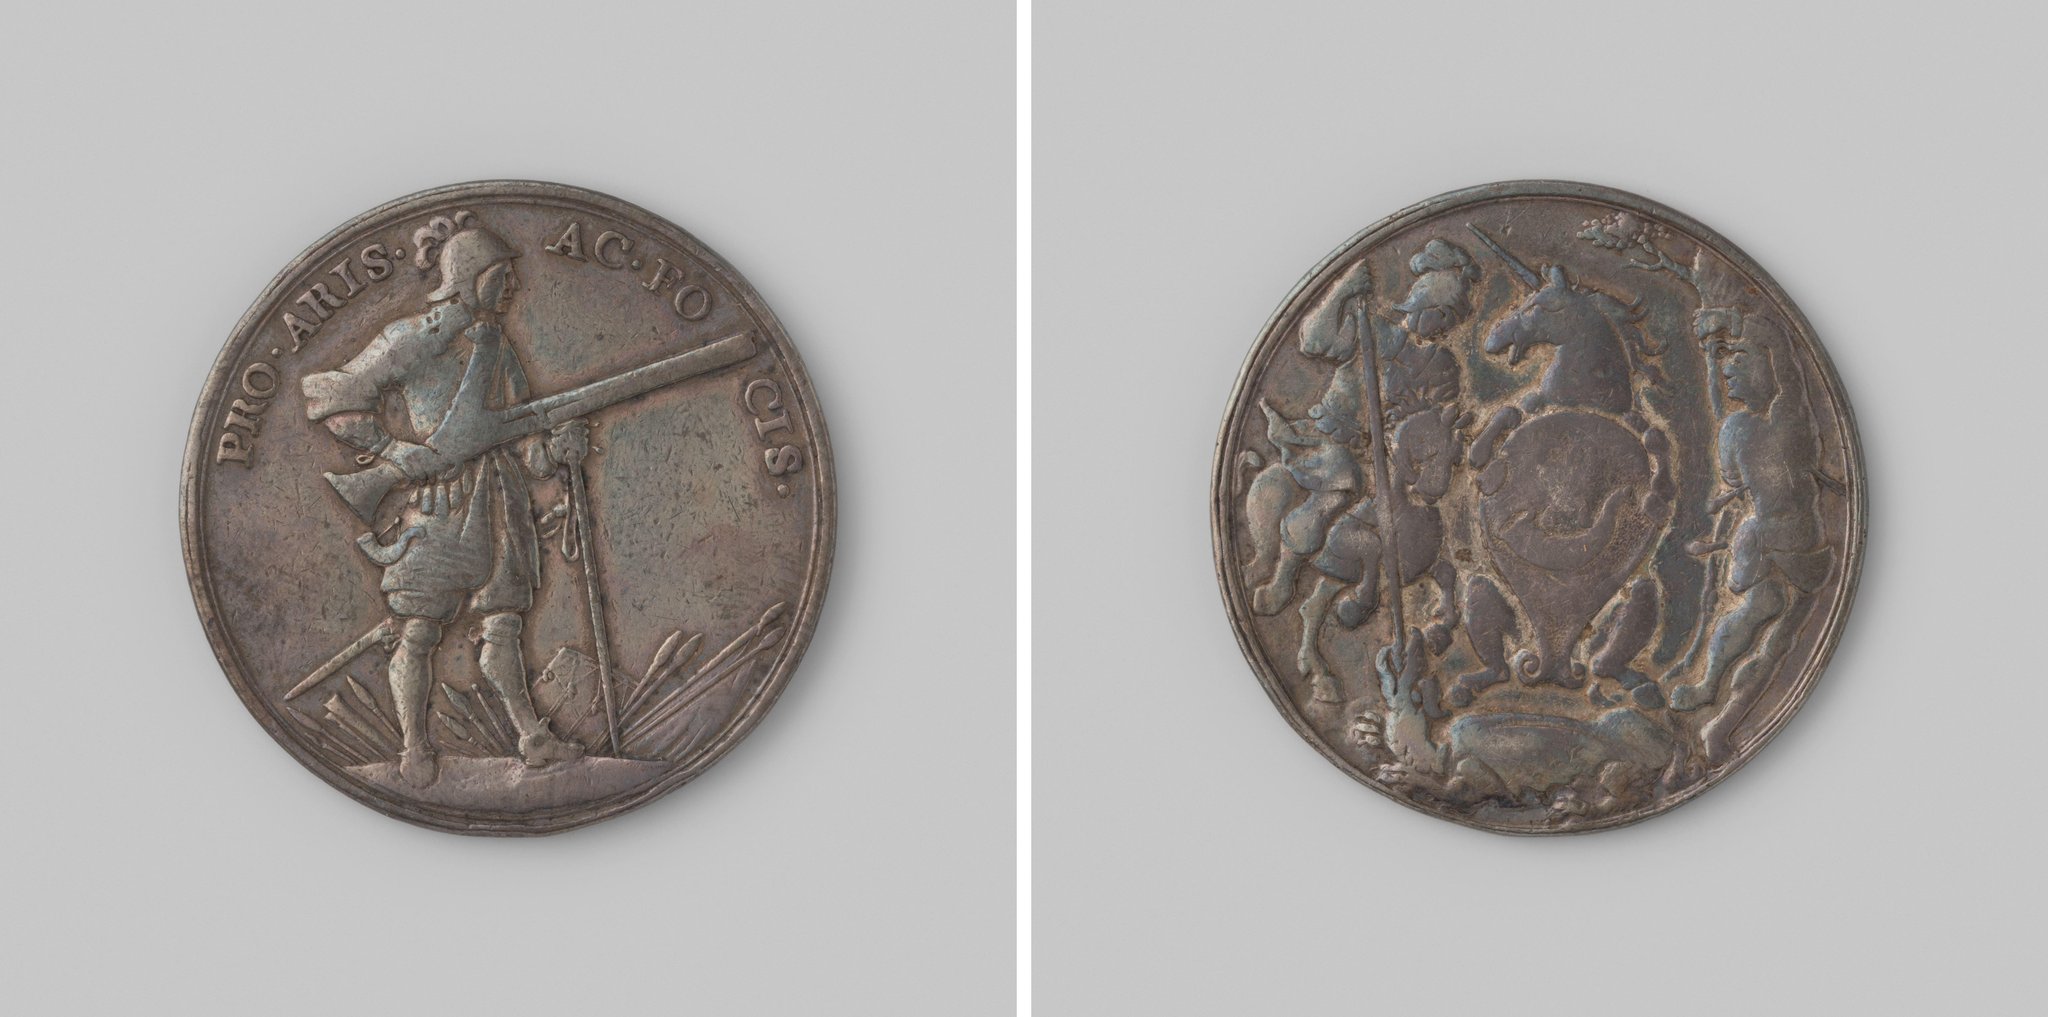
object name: marksman medal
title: Schutterspenning van Hoorn, officierspenning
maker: Anonymous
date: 1600-1700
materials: silver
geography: hoorn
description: Zilveren officierspenning van de schutterij Hoorn, 1e grootte. Voorzijde: Staande schutter met musket op een vork, "tot laden gereed", naar rechts. Omschrift PRO ARIS AC FOCIS (voor altaren en haardsteden). Keerzijde: het wapen van de stad Hoorn, vastgehouden door een eenhoorn, tussen Sint Joris en Sint Sebastiaan, schutspatronen van de beide stadsdoelen.